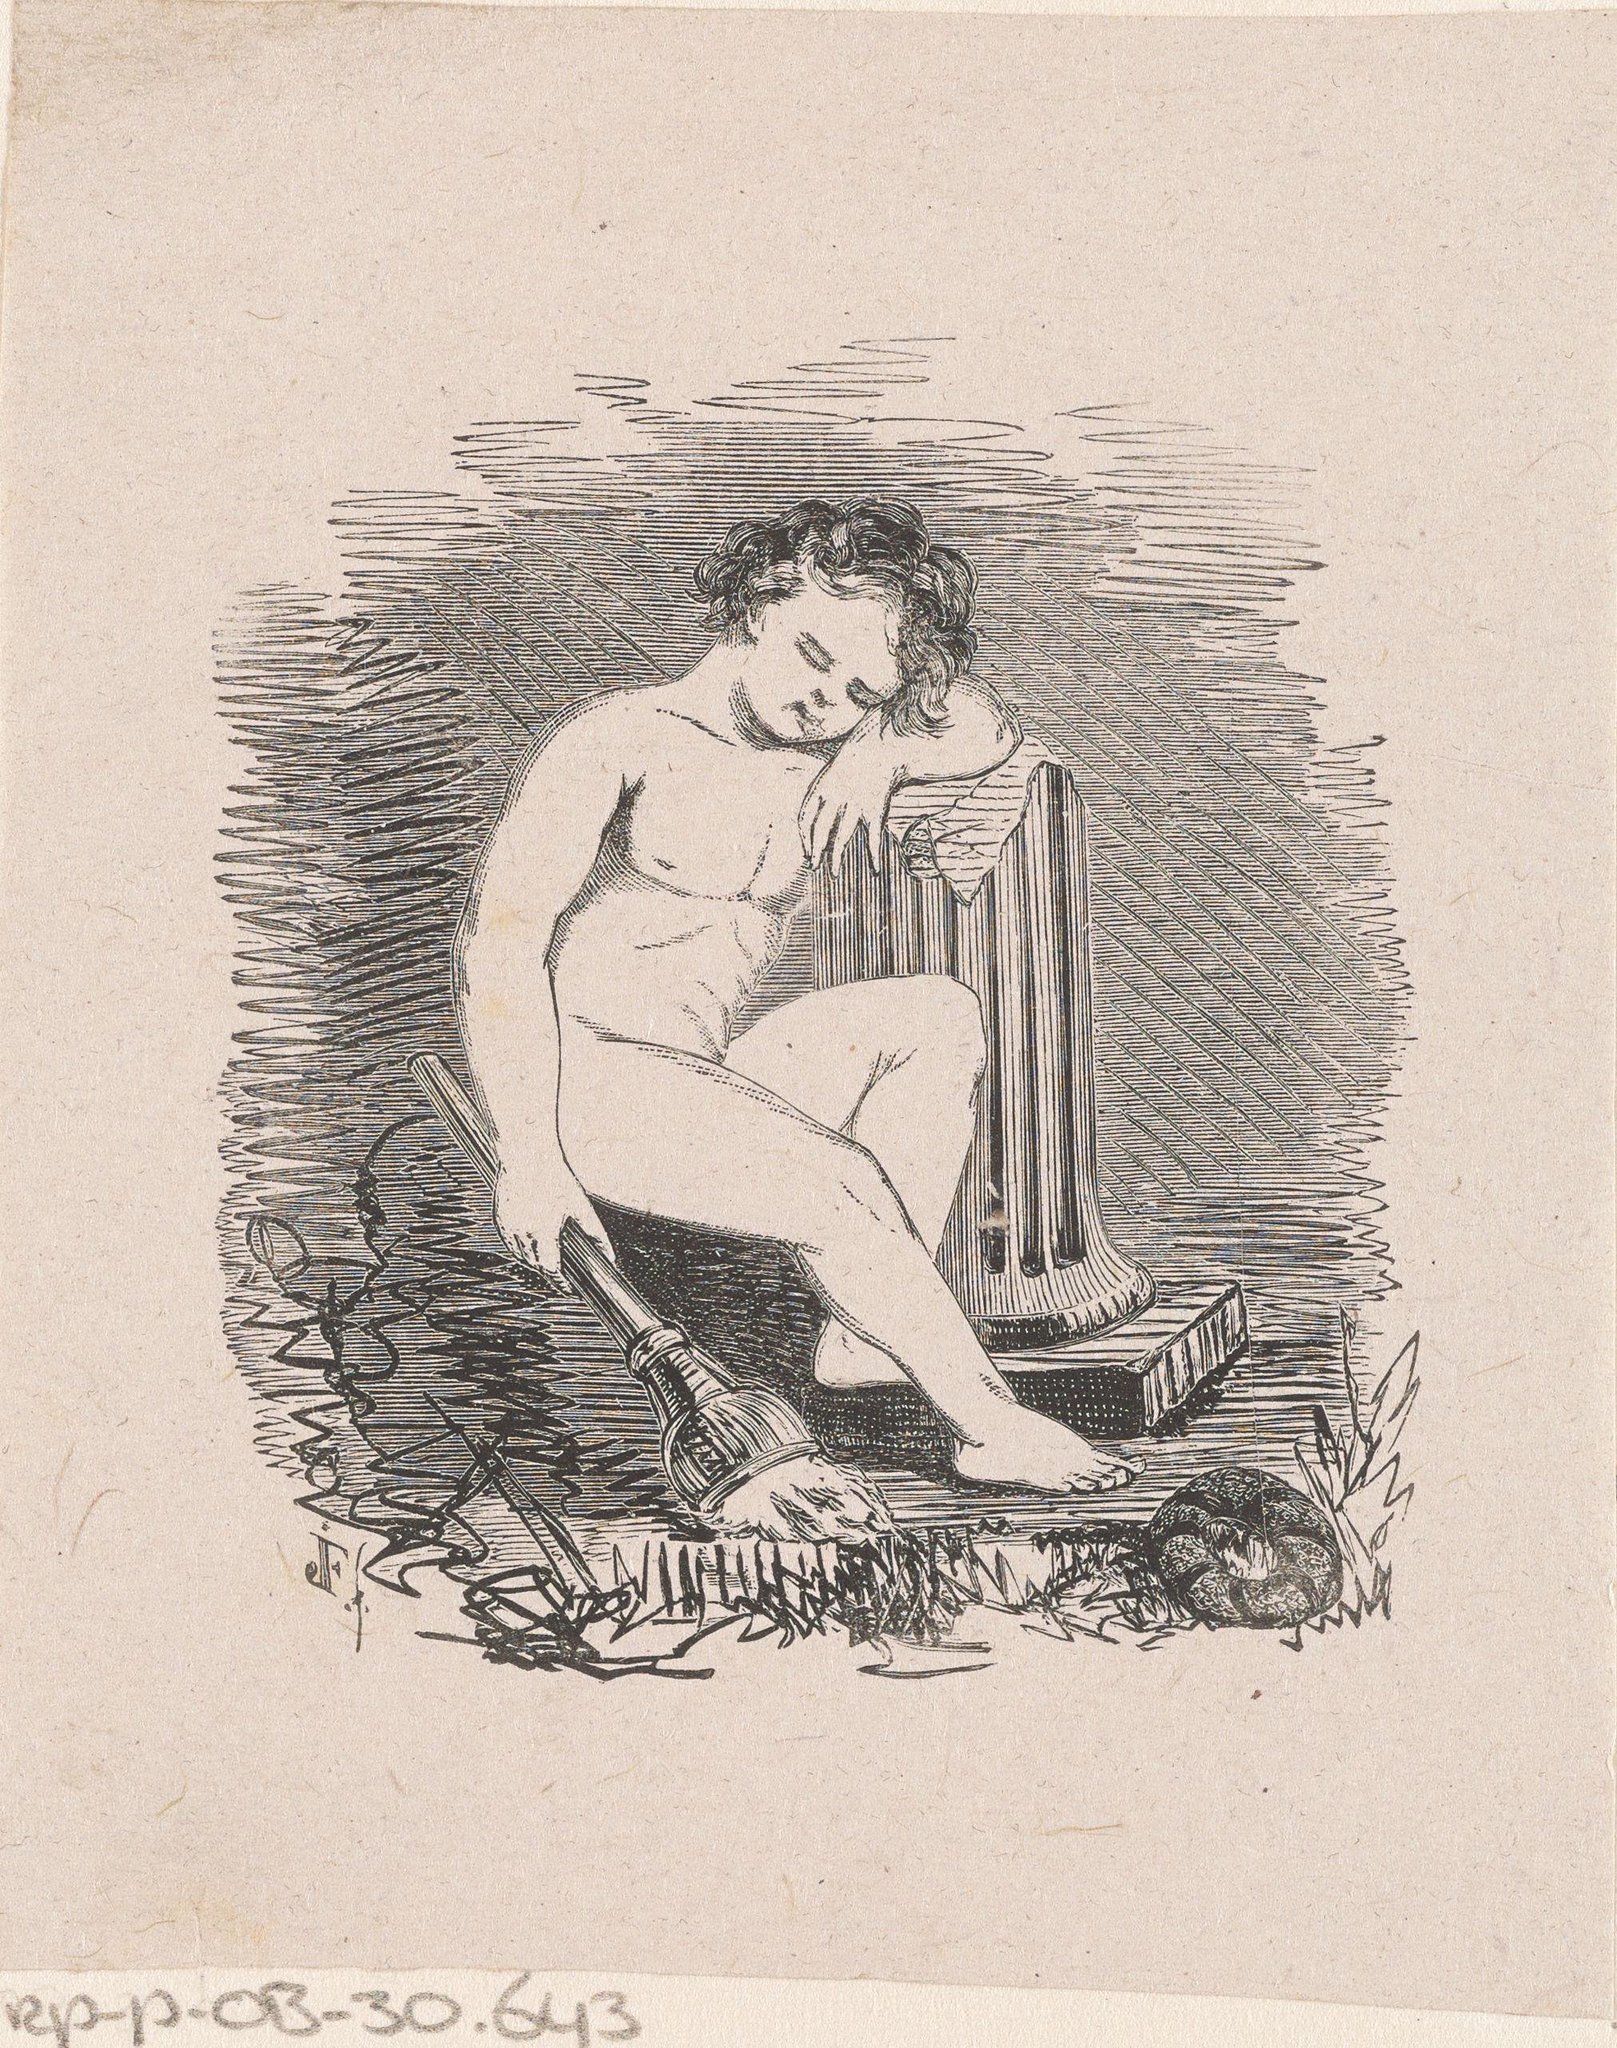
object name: print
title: Putto met een fakkel leunend op een halve pilaar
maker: isaac weissenbruch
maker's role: print maker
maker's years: 1826-1912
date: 1836-1912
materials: paper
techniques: engraving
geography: netherlands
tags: torch, base (~ column, pillar), cupids: 'amores', 'amoretti', 'putti'